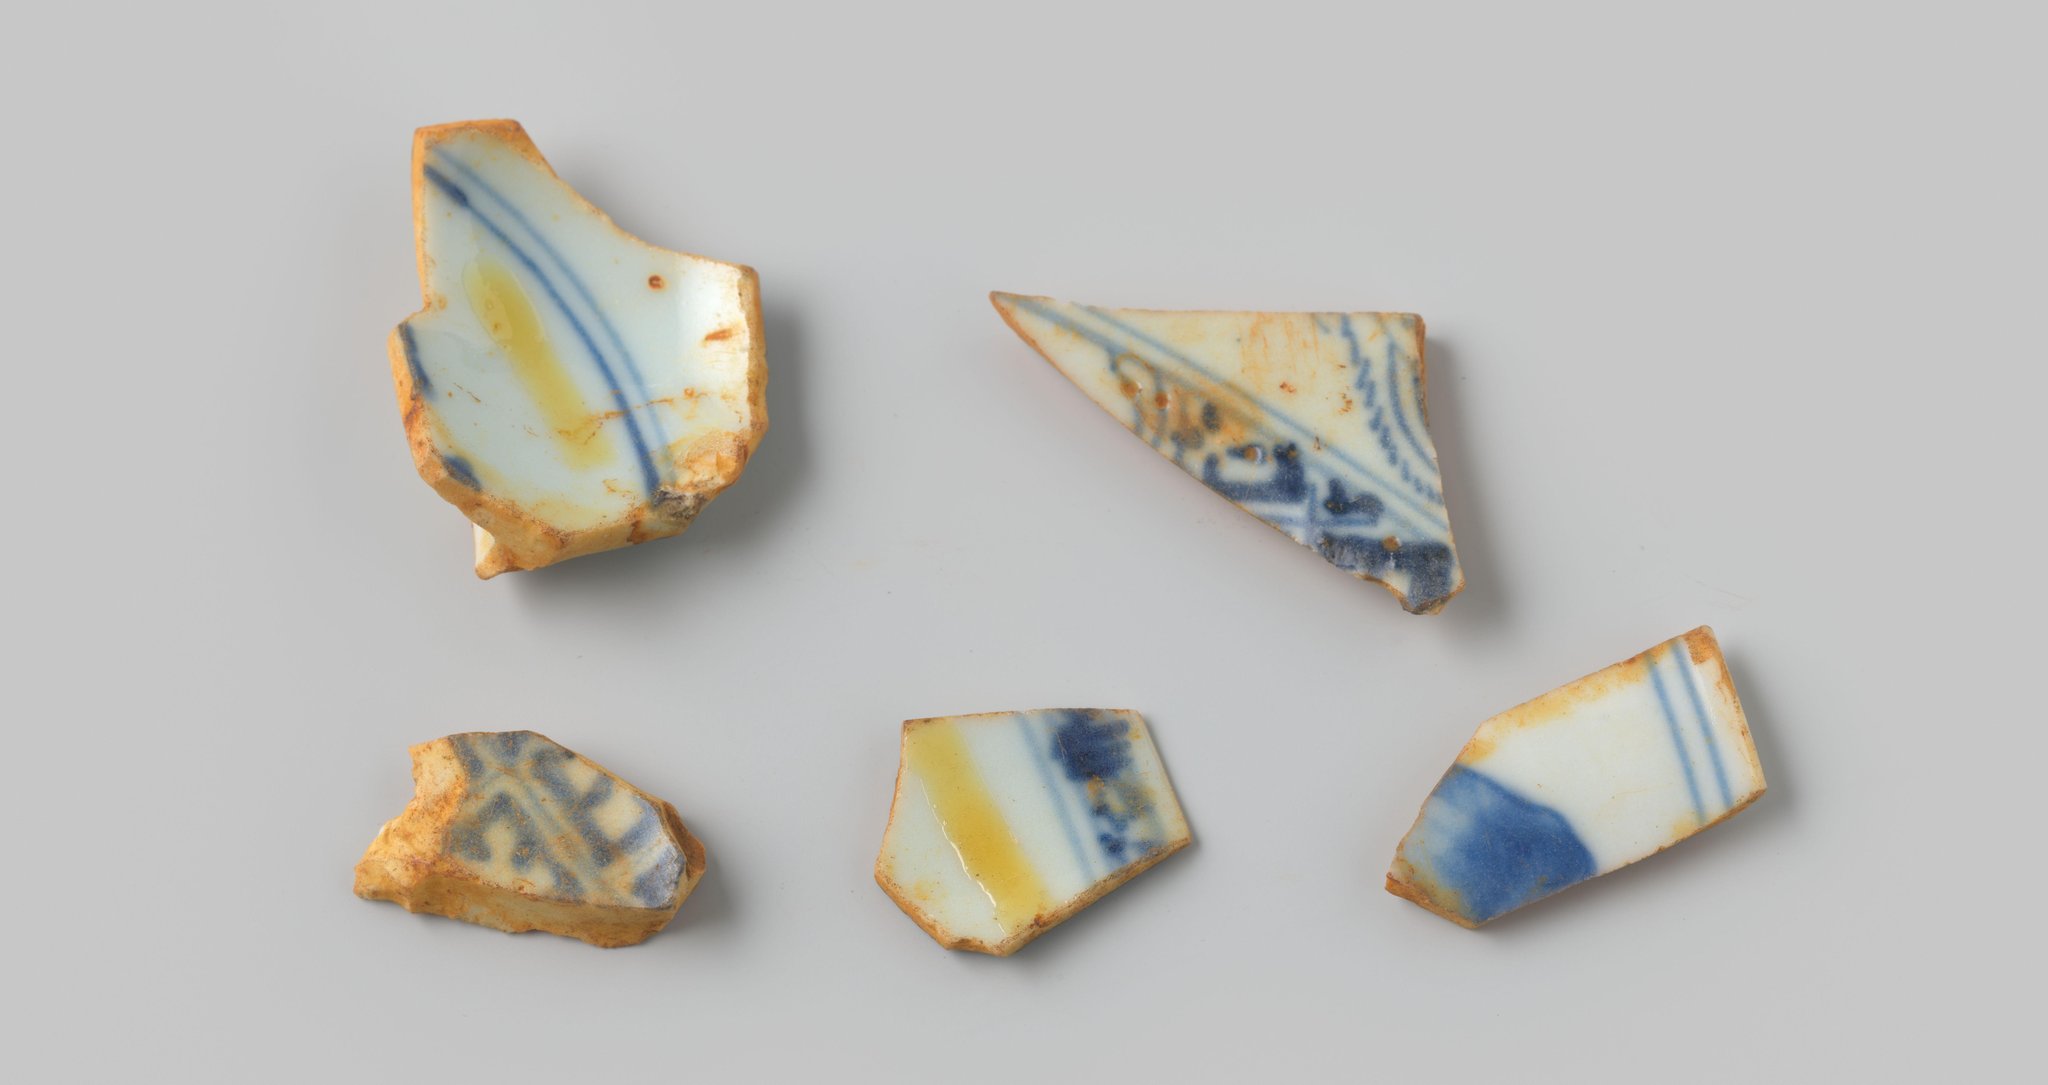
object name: platter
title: Scherven van schotels uit het wrak van de Oost-Indiëvaarder Hollandia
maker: Anonymous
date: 1700-1743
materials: porcelain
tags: verenigde oostindische compagnie, hollandia (schip)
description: Porcelain, saucer, type 2; fragm of base, sim. 79-209H1318.